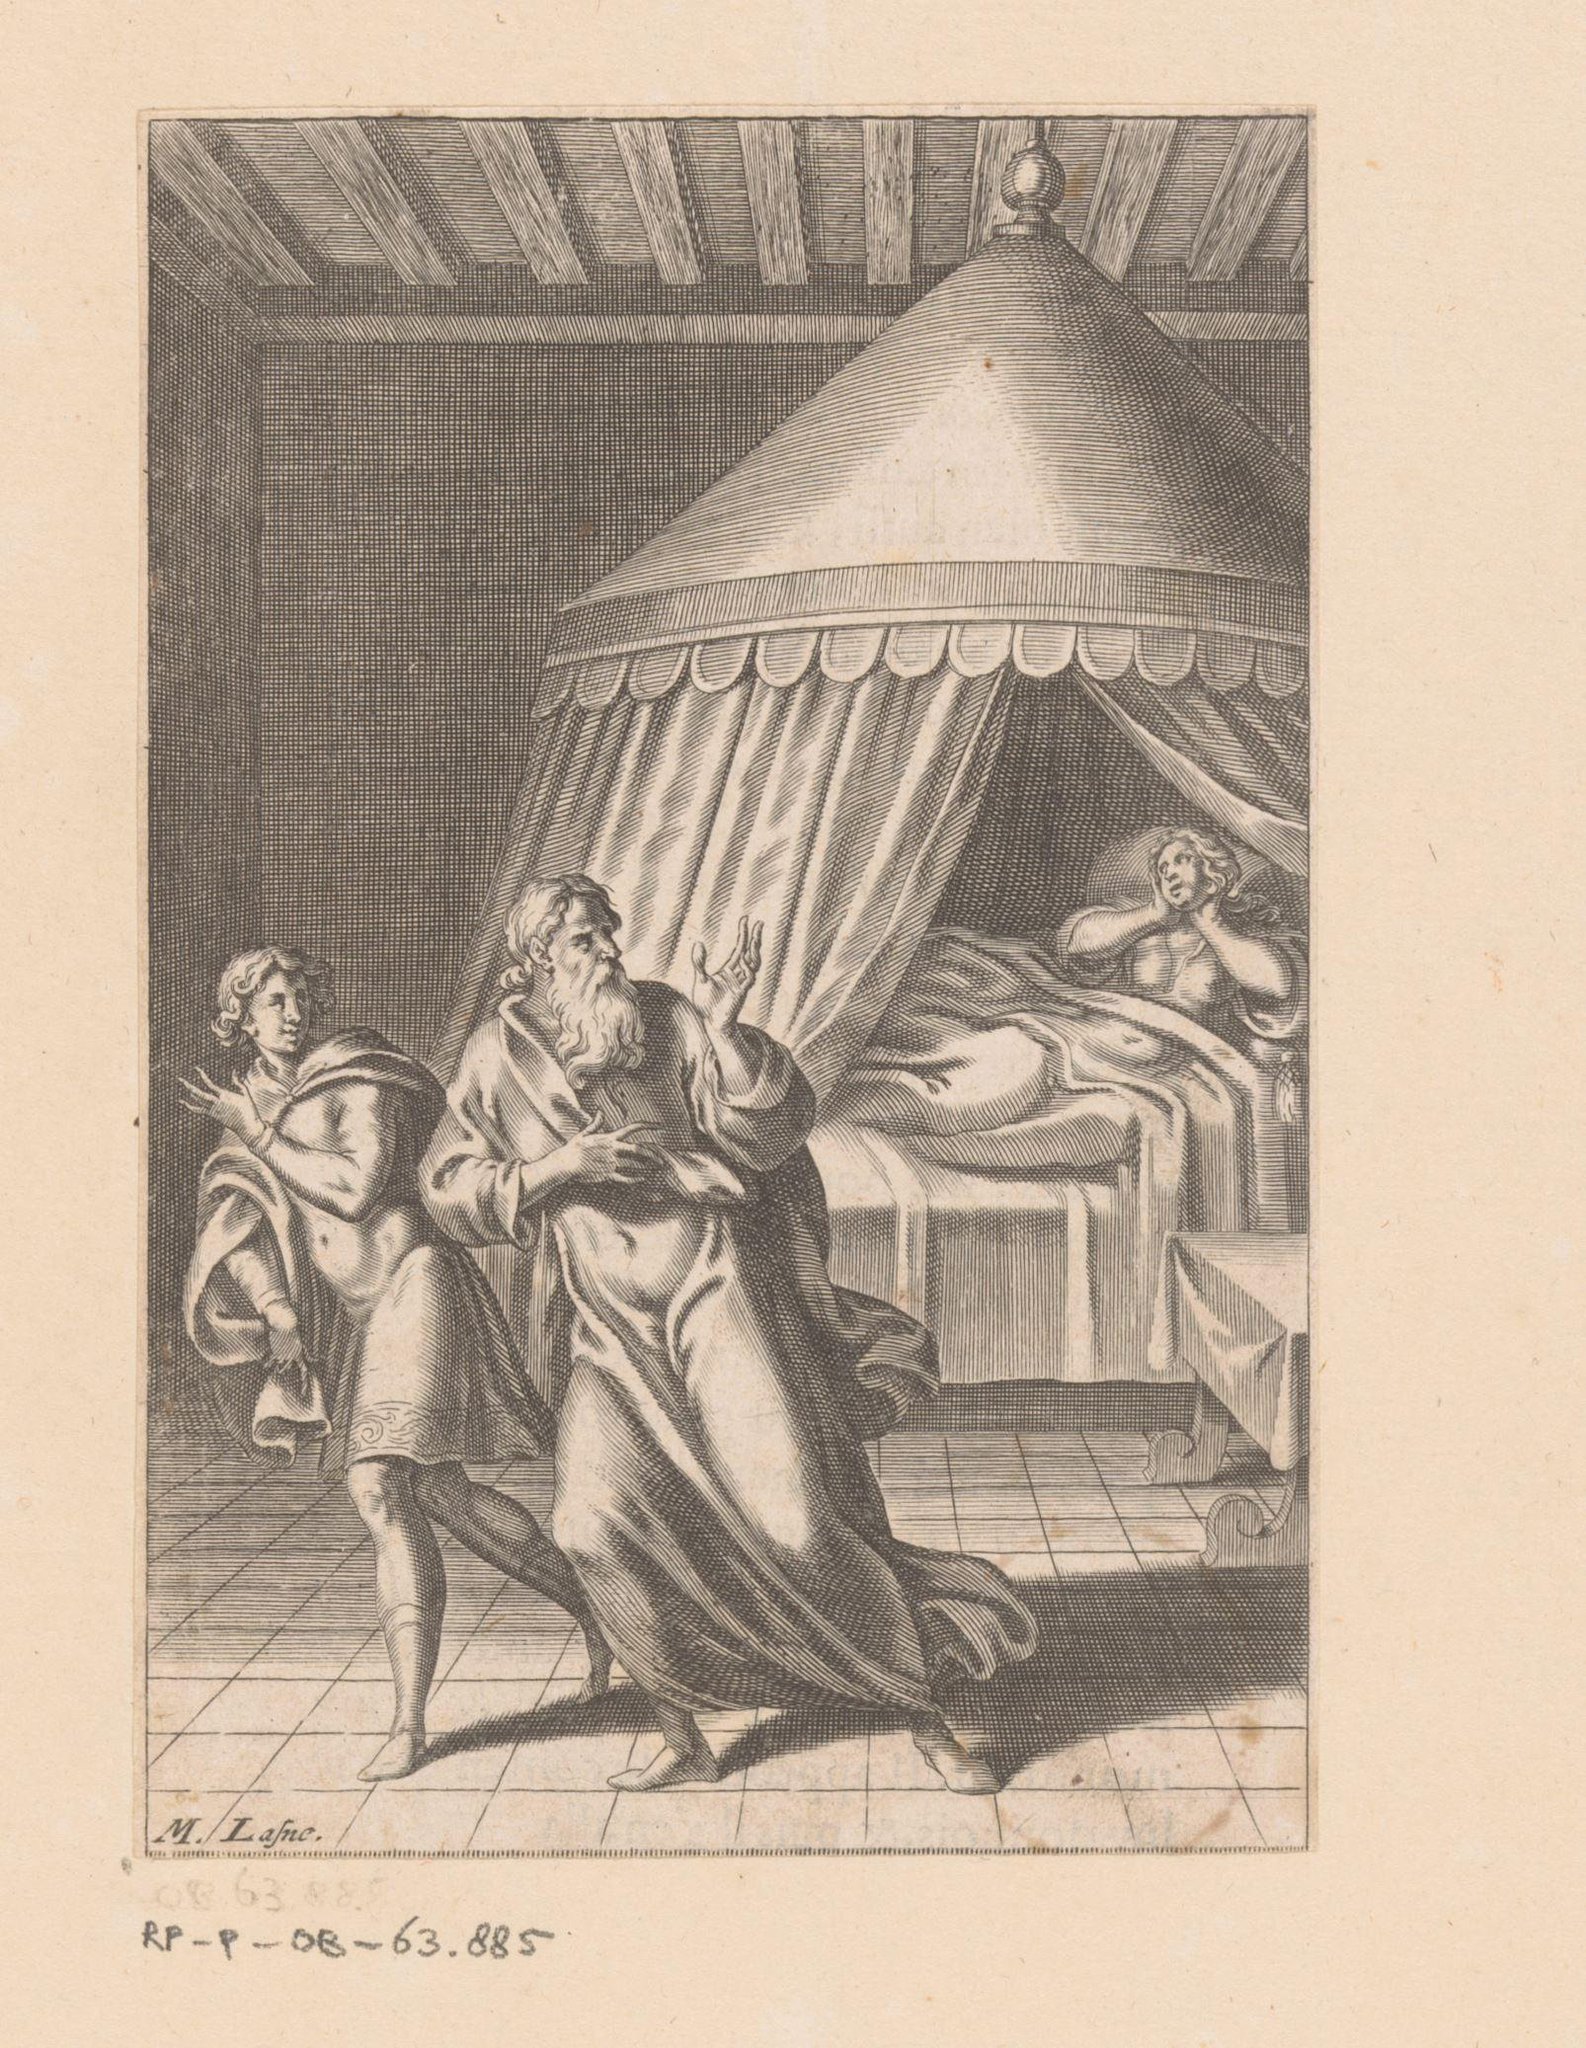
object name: book illustration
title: Alcamène ziet Chariclée, liggend in bed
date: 1623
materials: paper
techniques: engraving, letterpress printing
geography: paris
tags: bed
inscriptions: collector's mark: Lugt 240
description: Prent gebruikt voor: Emesenus, Heliodorus. Les amours de Théagène et Chariclée, / Histoire éthiopique de Heliodore. Parijs: Samuel Thiboust, 1623, p. 266.